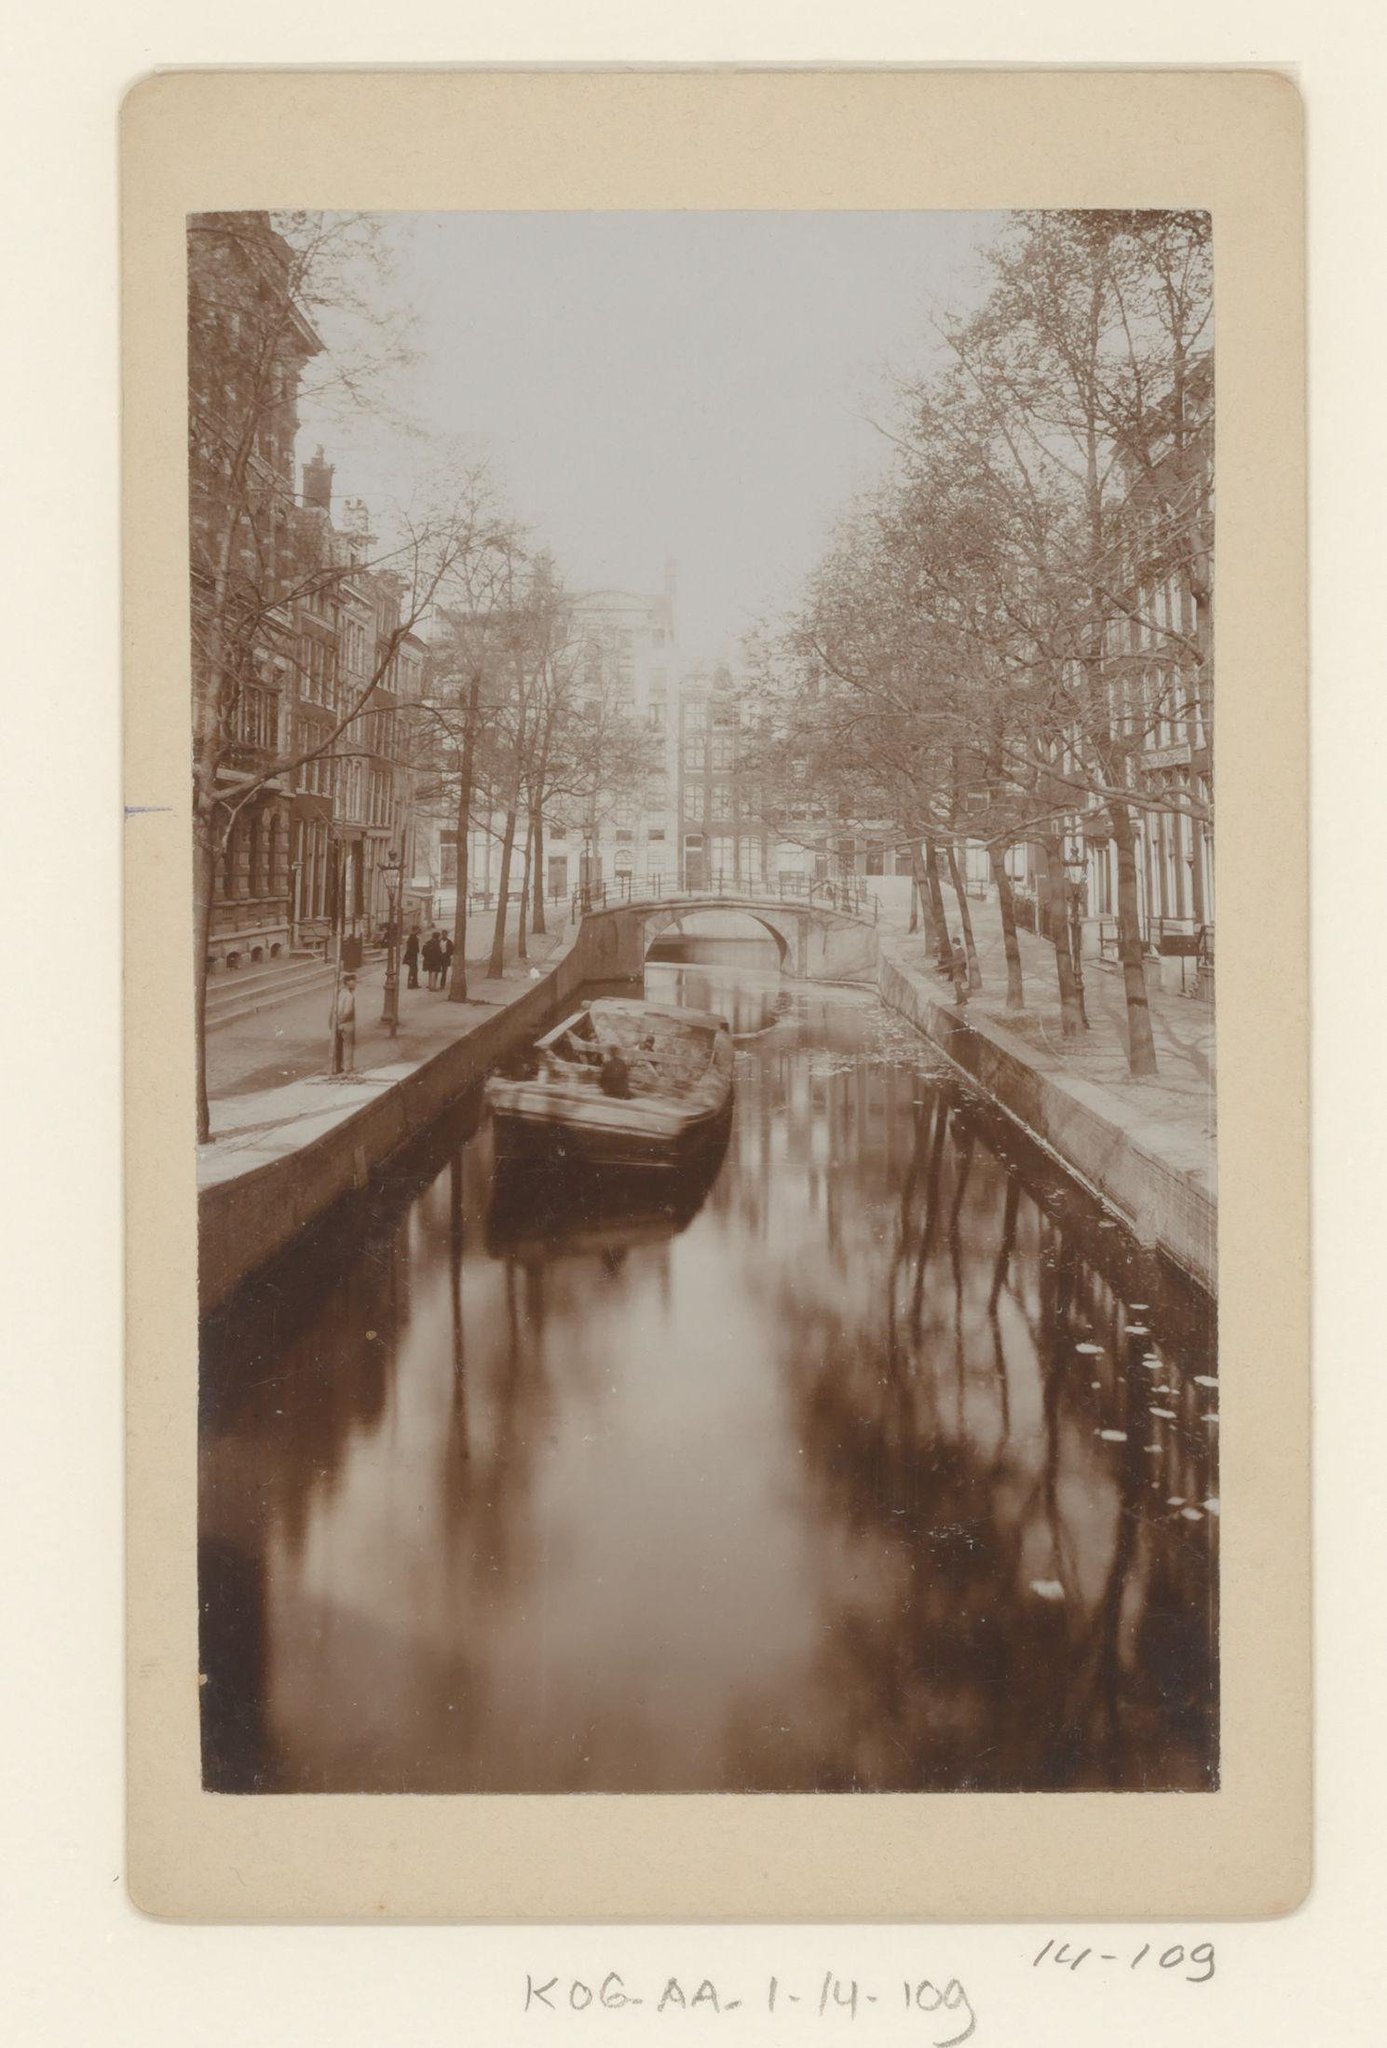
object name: cabinet photograph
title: Gezicht op de Warmoesgracht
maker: Anonymous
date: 1865-1894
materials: paper, cardboard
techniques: collodion silver print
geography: amsterdam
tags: city-view in general; 'veduta', canal, bridge in city across river, canal, etc., street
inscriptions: collector's mark: ‘14 109’ Lugt 1641b, inscription: ‘no 37 Leidschegracht / Warmoes / n/d Heerengracht te zien, vóór / de doorbraak van de laatste. / 13x18: 483’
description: Onderwerpsrubriek binnen de Atlas Amsterdam: Waal (Kromme en Oude), Walenpleintje, Warmoesgracht, Warmoesstraat, Waterlooplein, Westerdoksdijk, Westermarkt, Weteringschans, Willemspark, Willemsstraat, Wittenburg, Wittenkade (de), Wittenstraat (de).